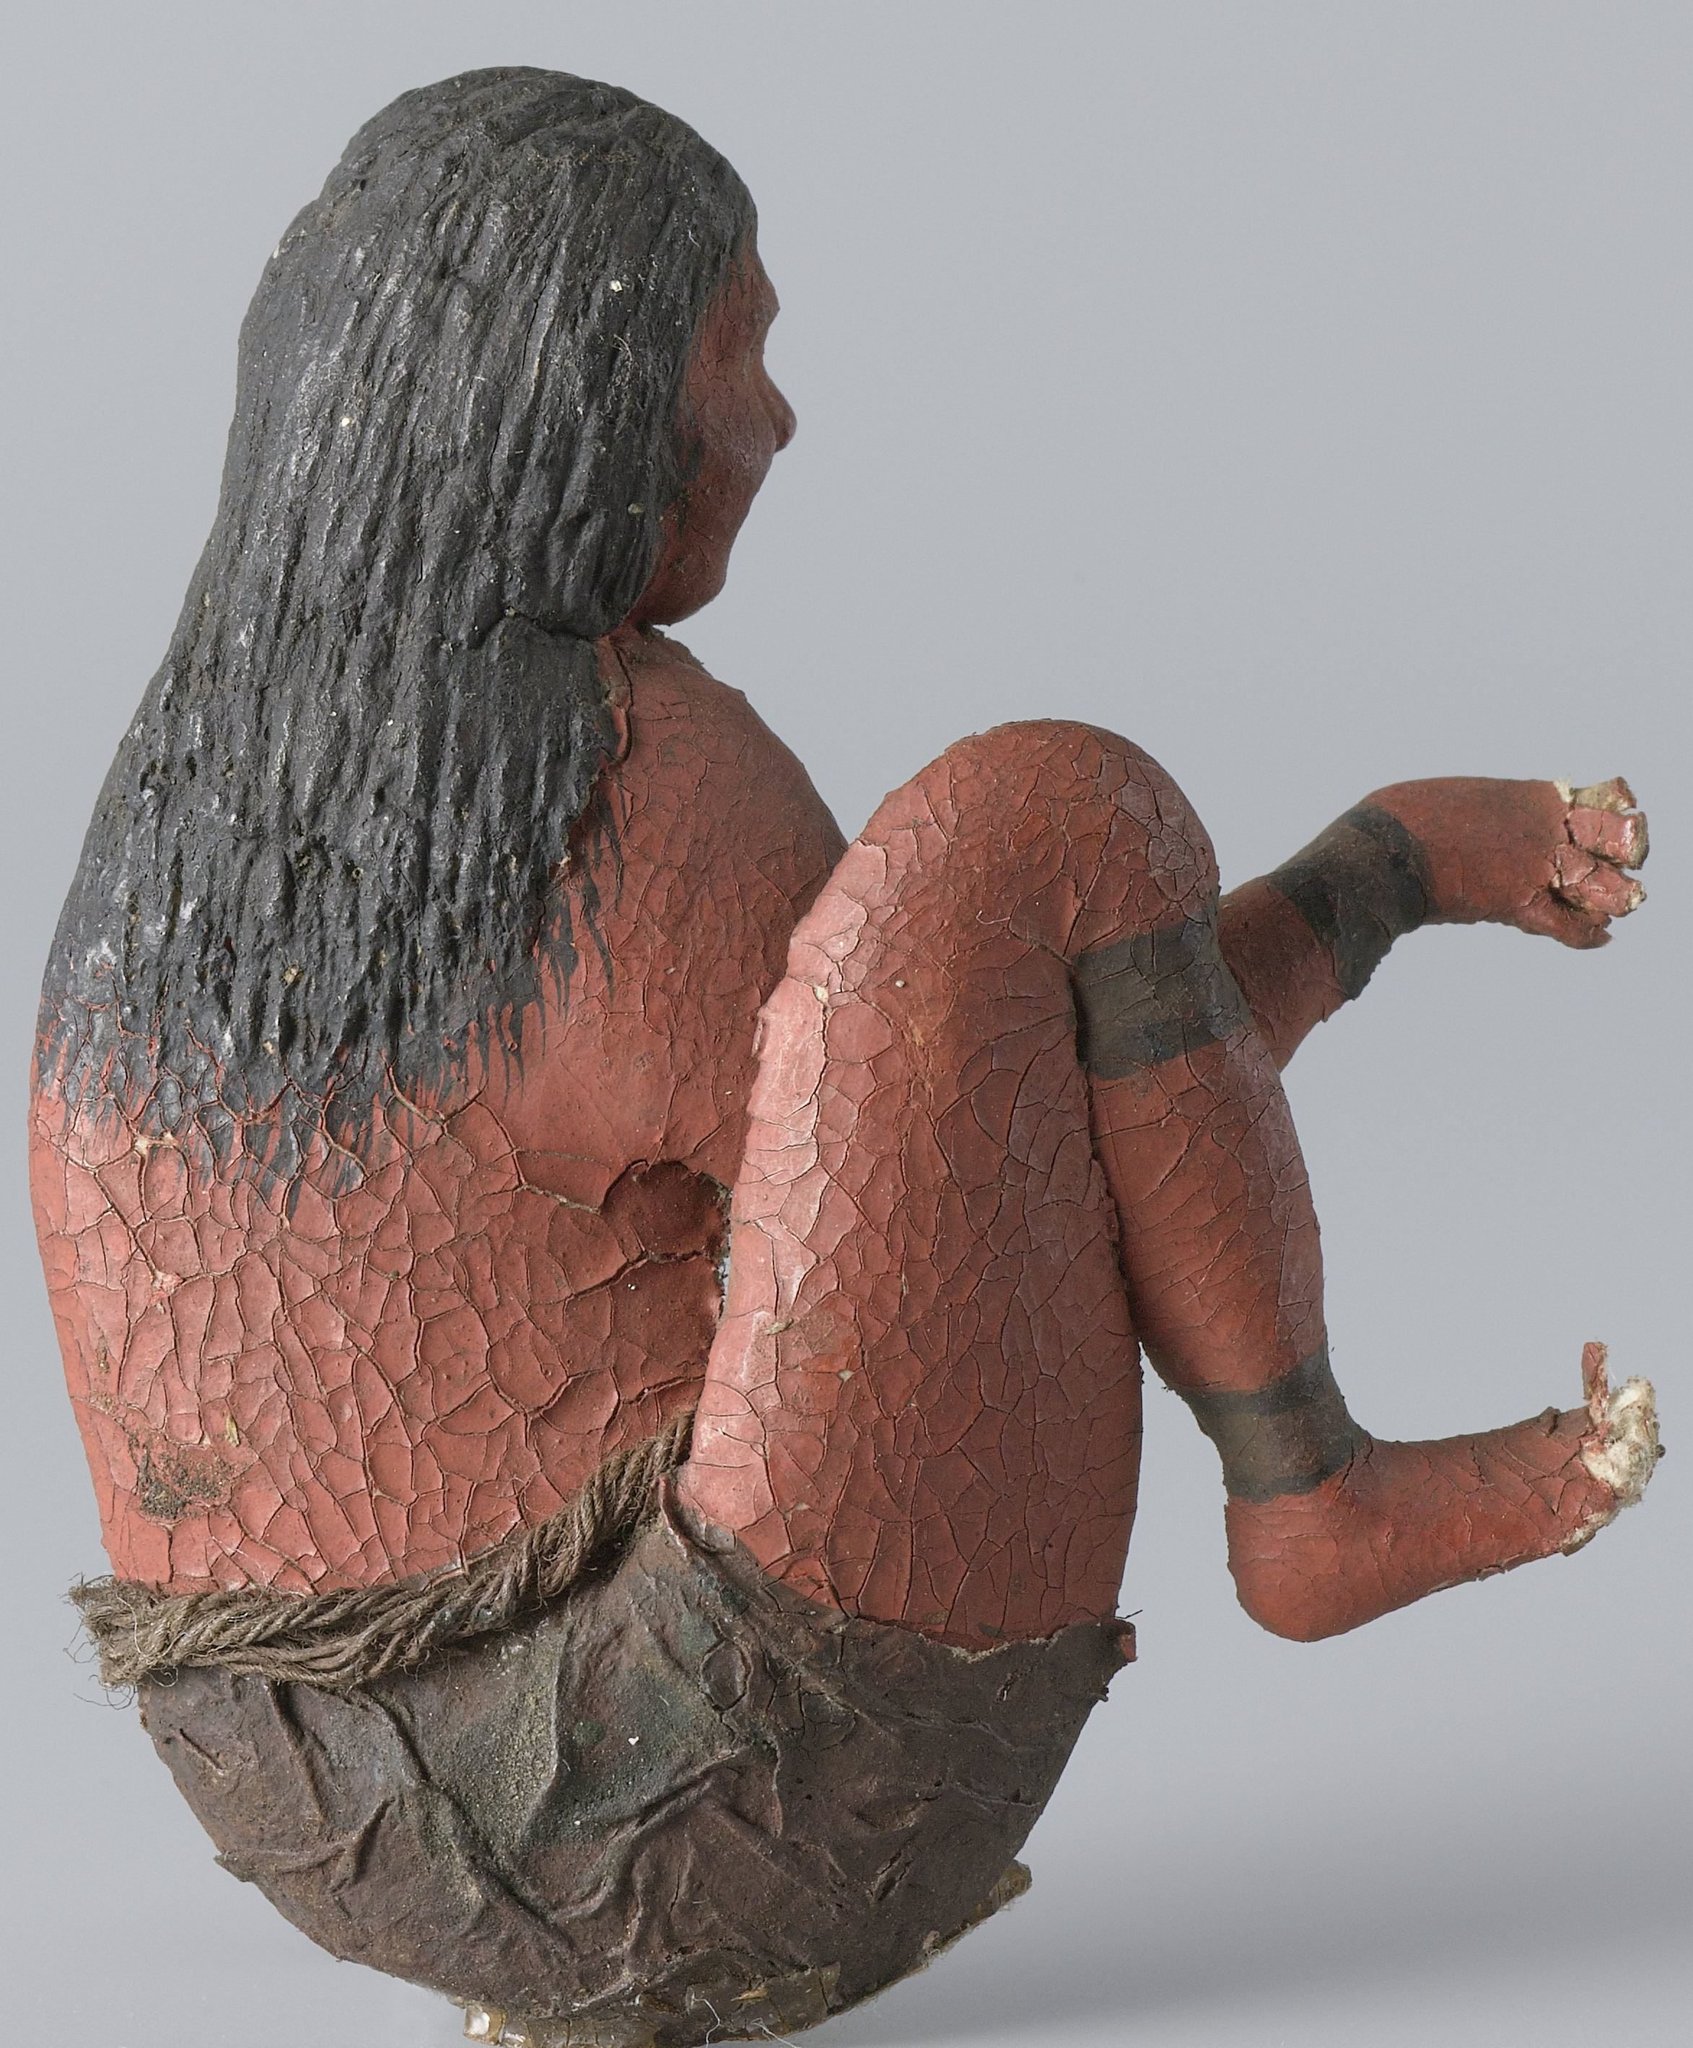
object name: figure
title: Zittende Caraïb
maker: gerrit schouten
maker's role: draughtsman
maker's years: 1779-1839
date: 1810-1839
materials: glue, paint, paper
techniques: modeling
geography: suriname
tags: indigenous peoples of south america, suriname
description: Een los figuur uit een diorama van Gerrit Schouten, voorstellende een zittende Caraïb, van achteren gezien. De vrouw kan als Caraïb herkend worden door de beenbanden.